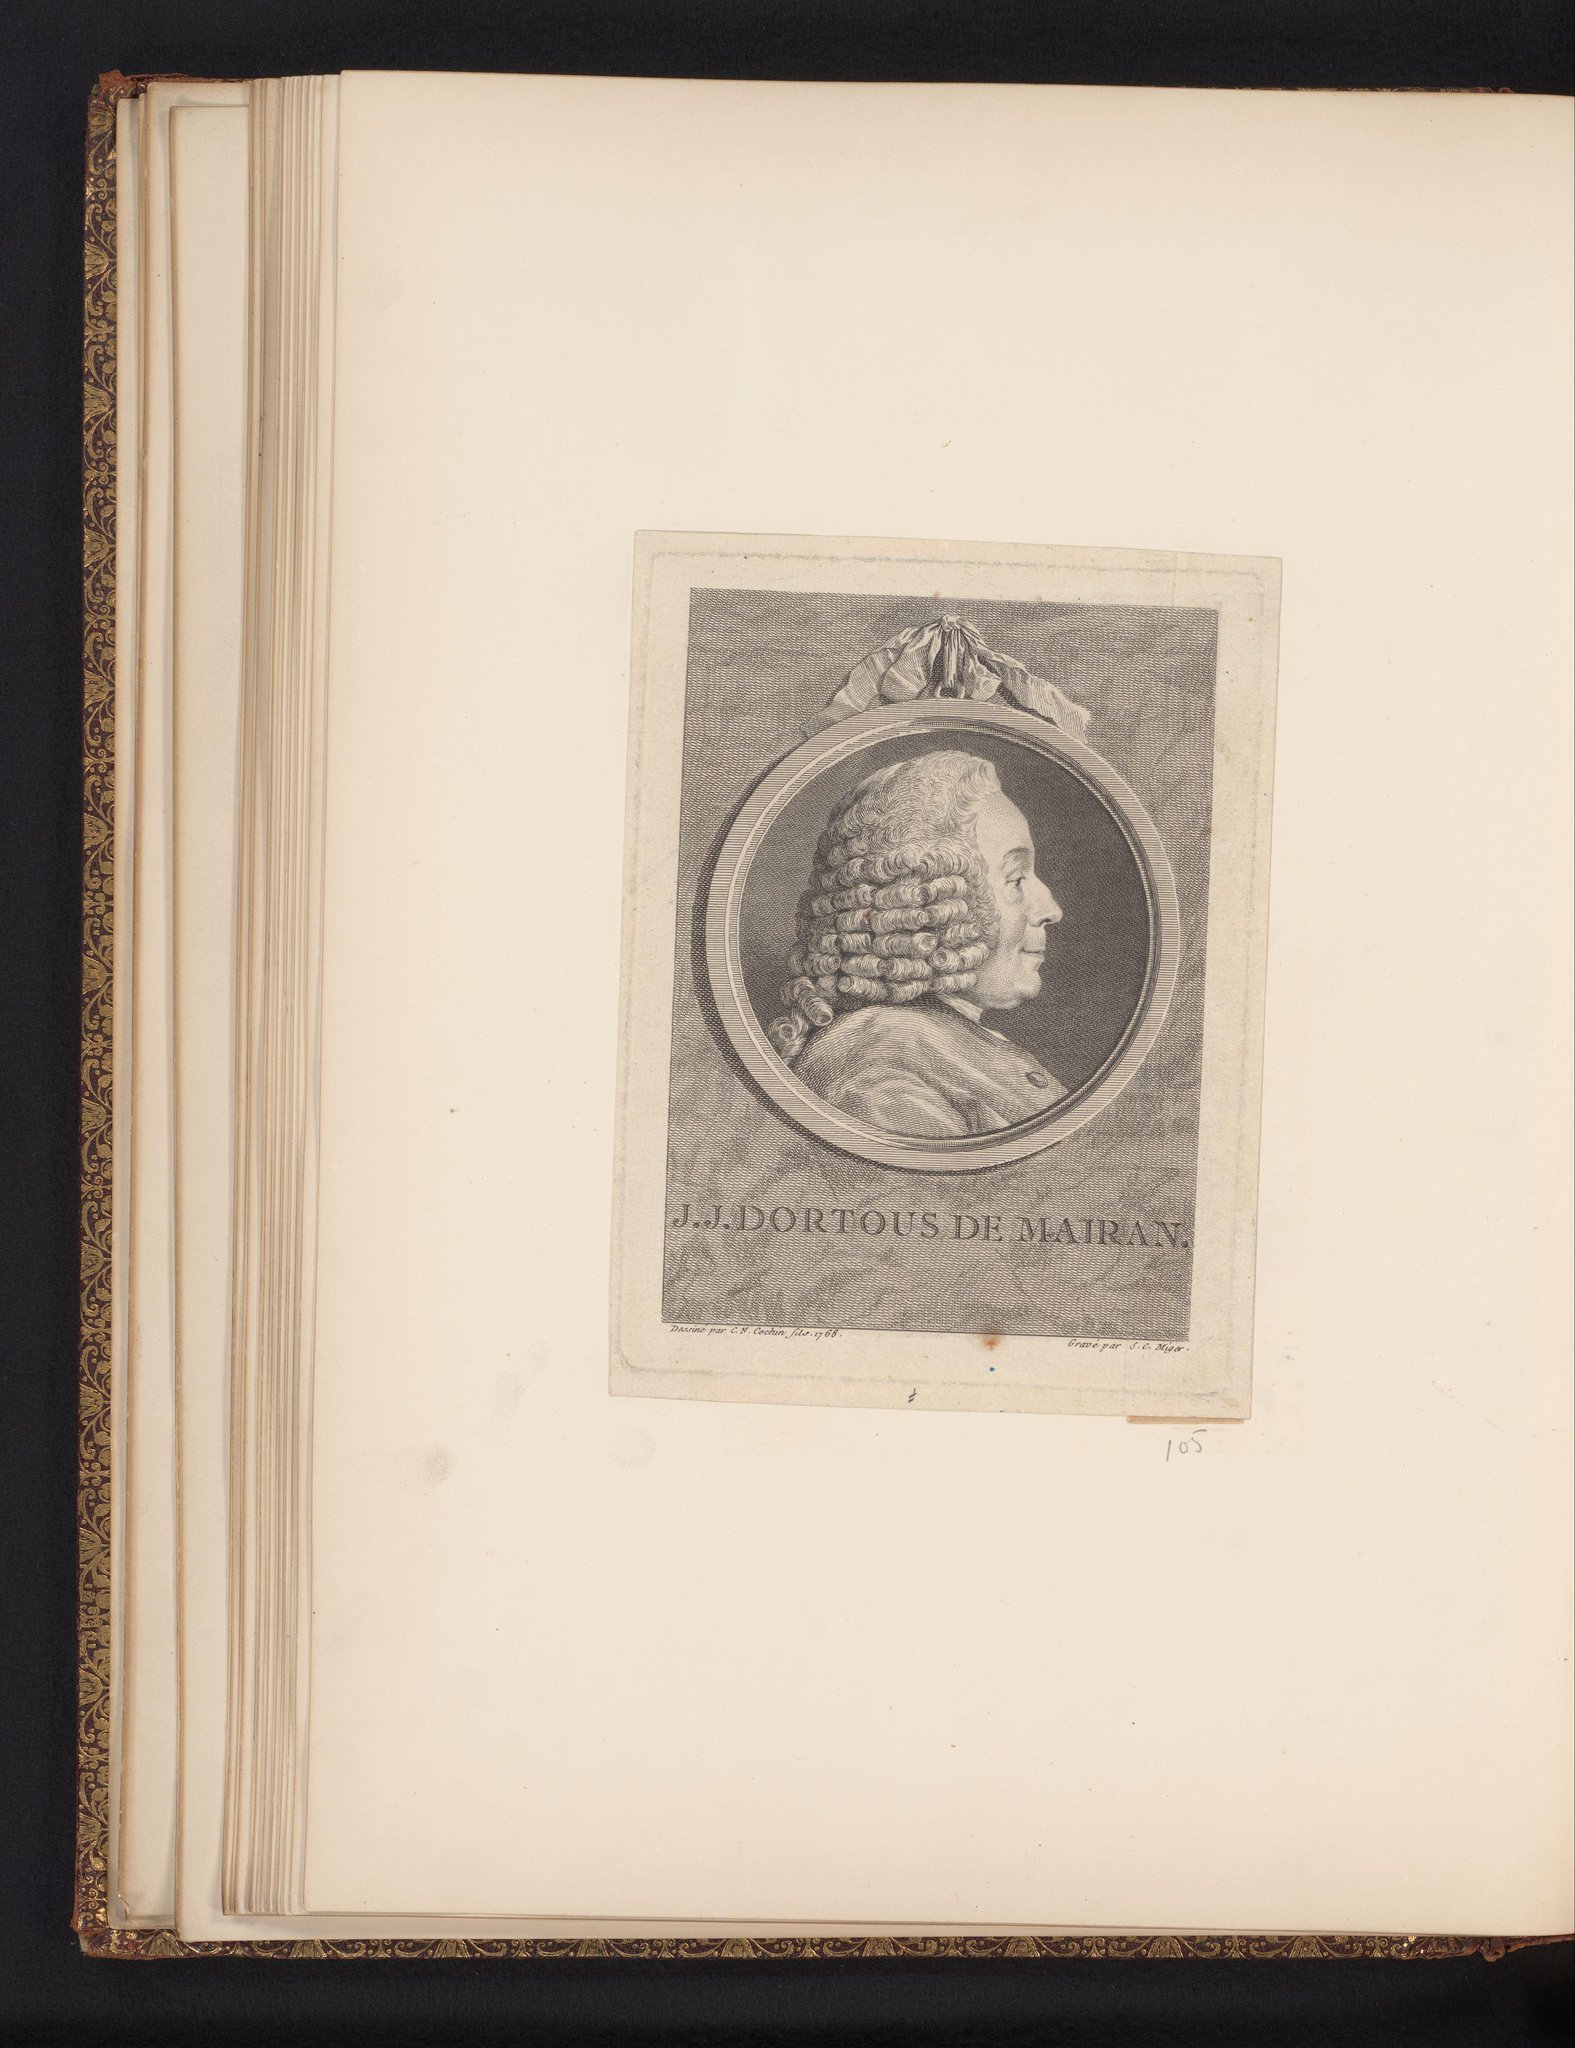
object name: print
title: Portret van Jean Jacques de Mairan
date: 1768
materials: paper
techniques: engraving, etching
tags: france, historical persons, mathematics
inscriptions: date